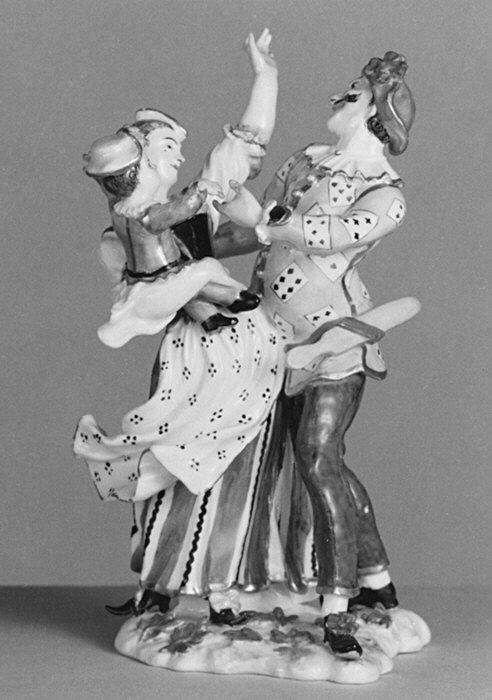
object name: group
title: The Harlequin Family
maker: meissen manufactory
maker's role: manufactory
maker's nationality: german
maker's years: 1710-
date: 1740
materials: hard paste porcelain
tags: men,women,family,clowns